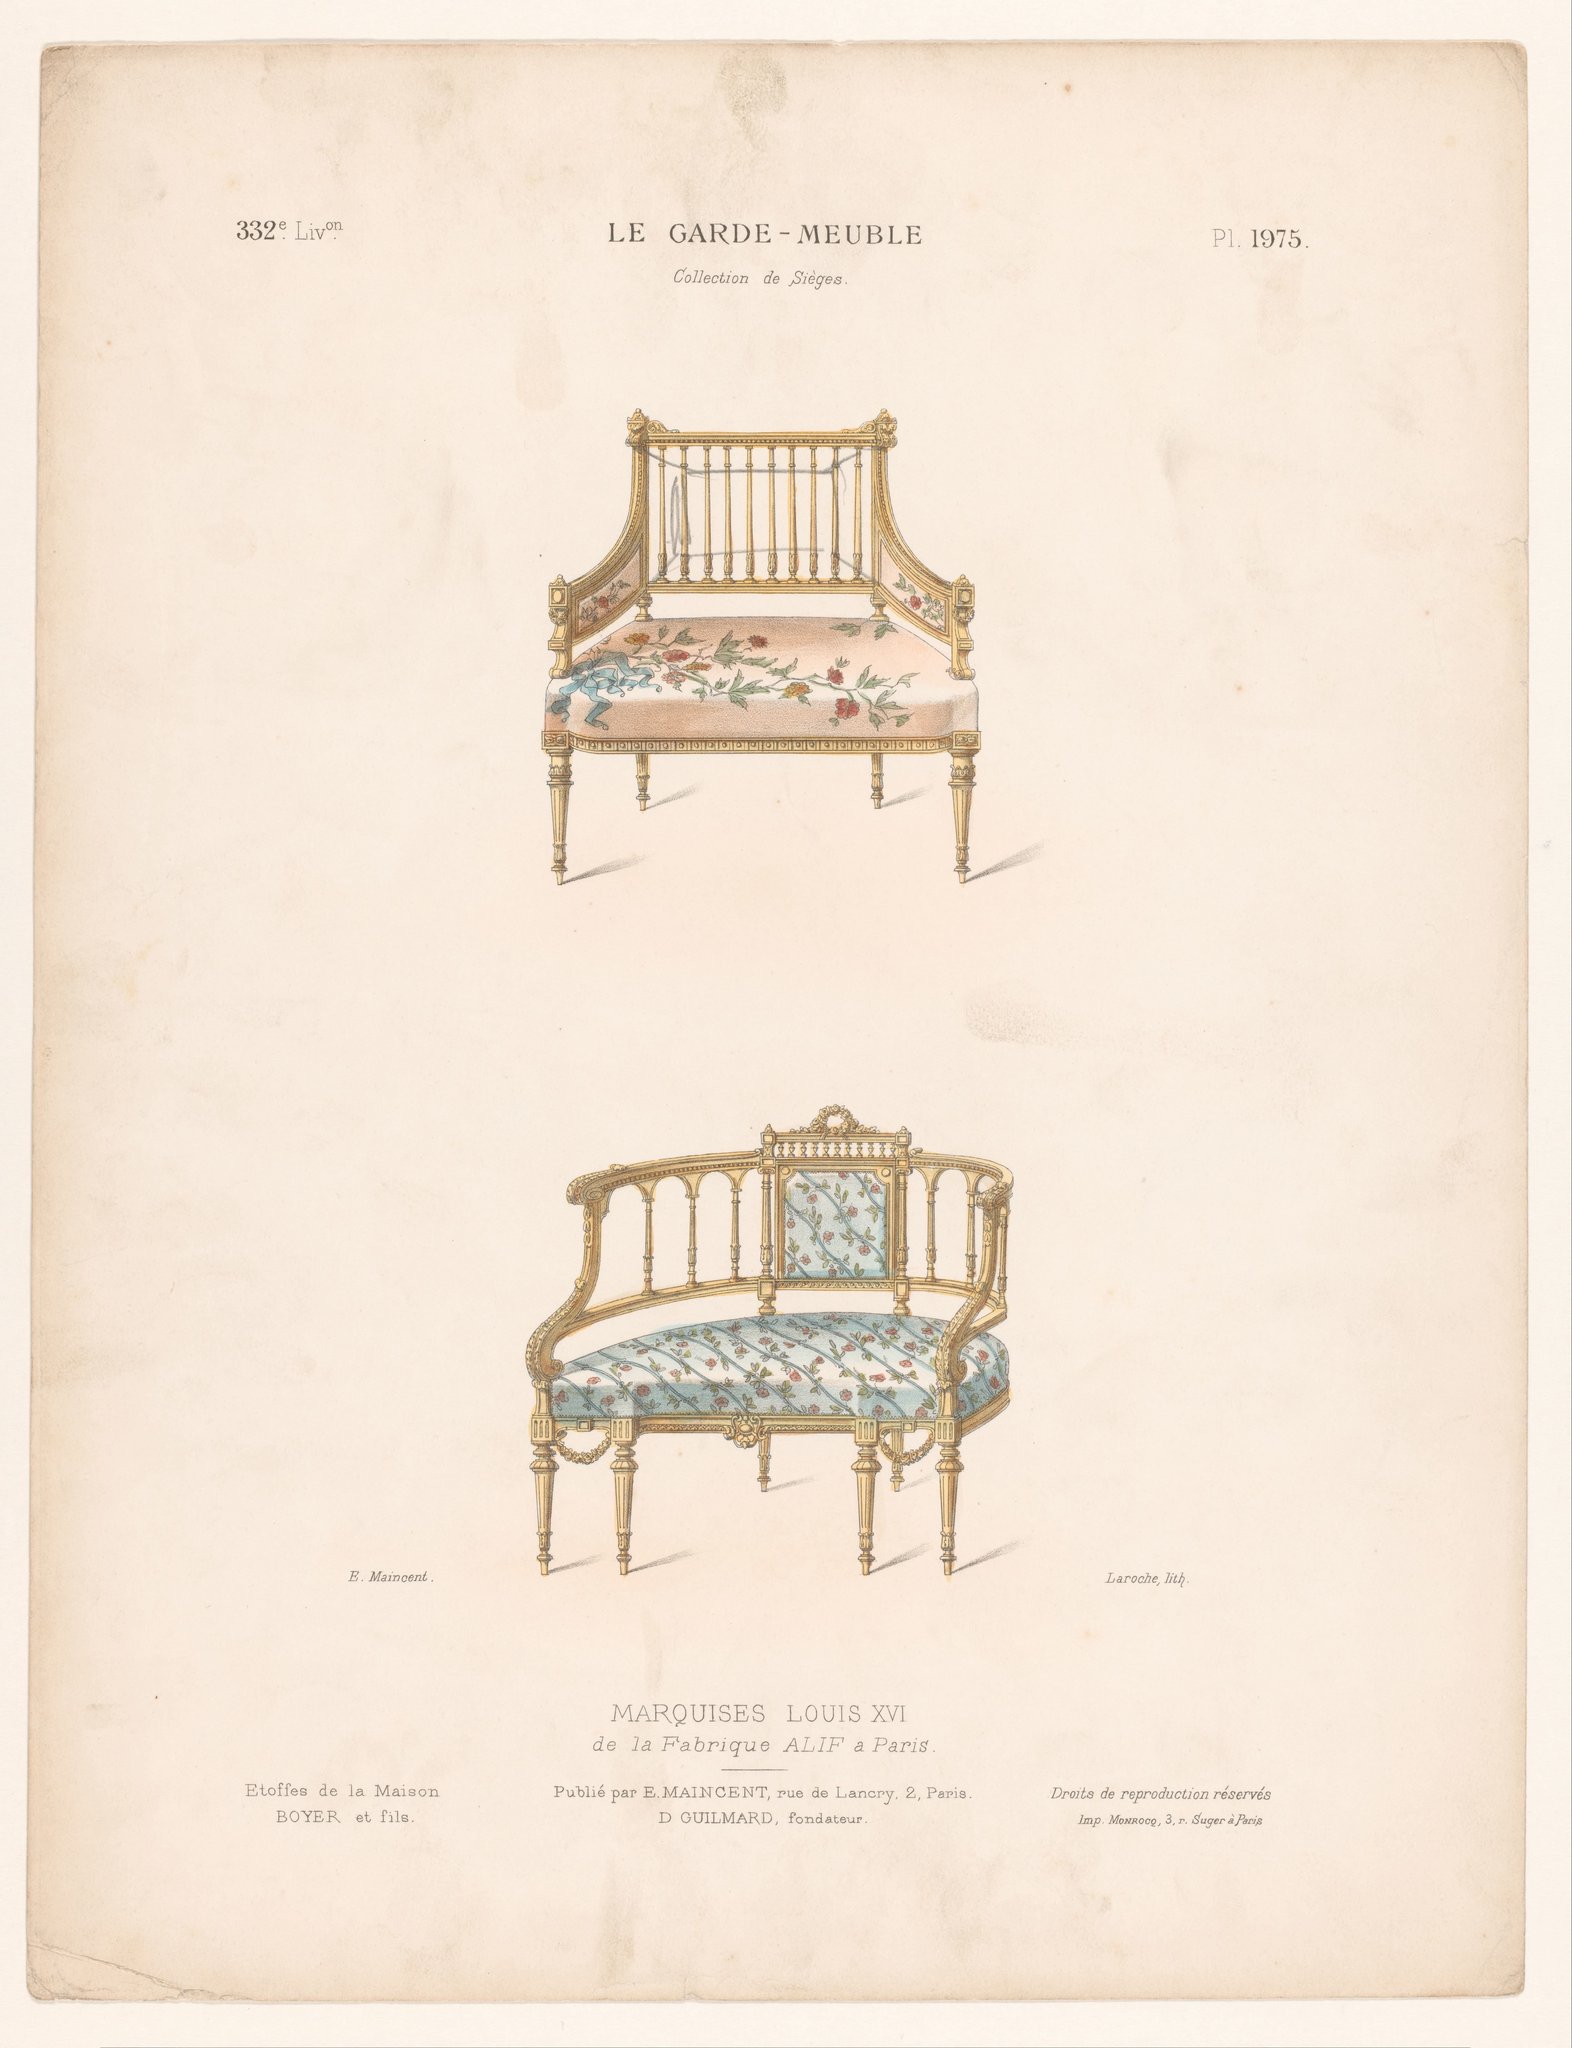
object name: print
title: Marquises Louis XVI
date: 1885-1895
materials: paper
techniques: hand coloring, lithograph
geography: paris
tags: seating furniture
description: Ieder Livraison in de serie Le Garde-Meuble bevat negen platen: drie 'sièges' (zitmeubels), drie 'meubles' (diverse meubels zoals tafels en kasten) en drie 'tentures' (gordijnen en draperieën).